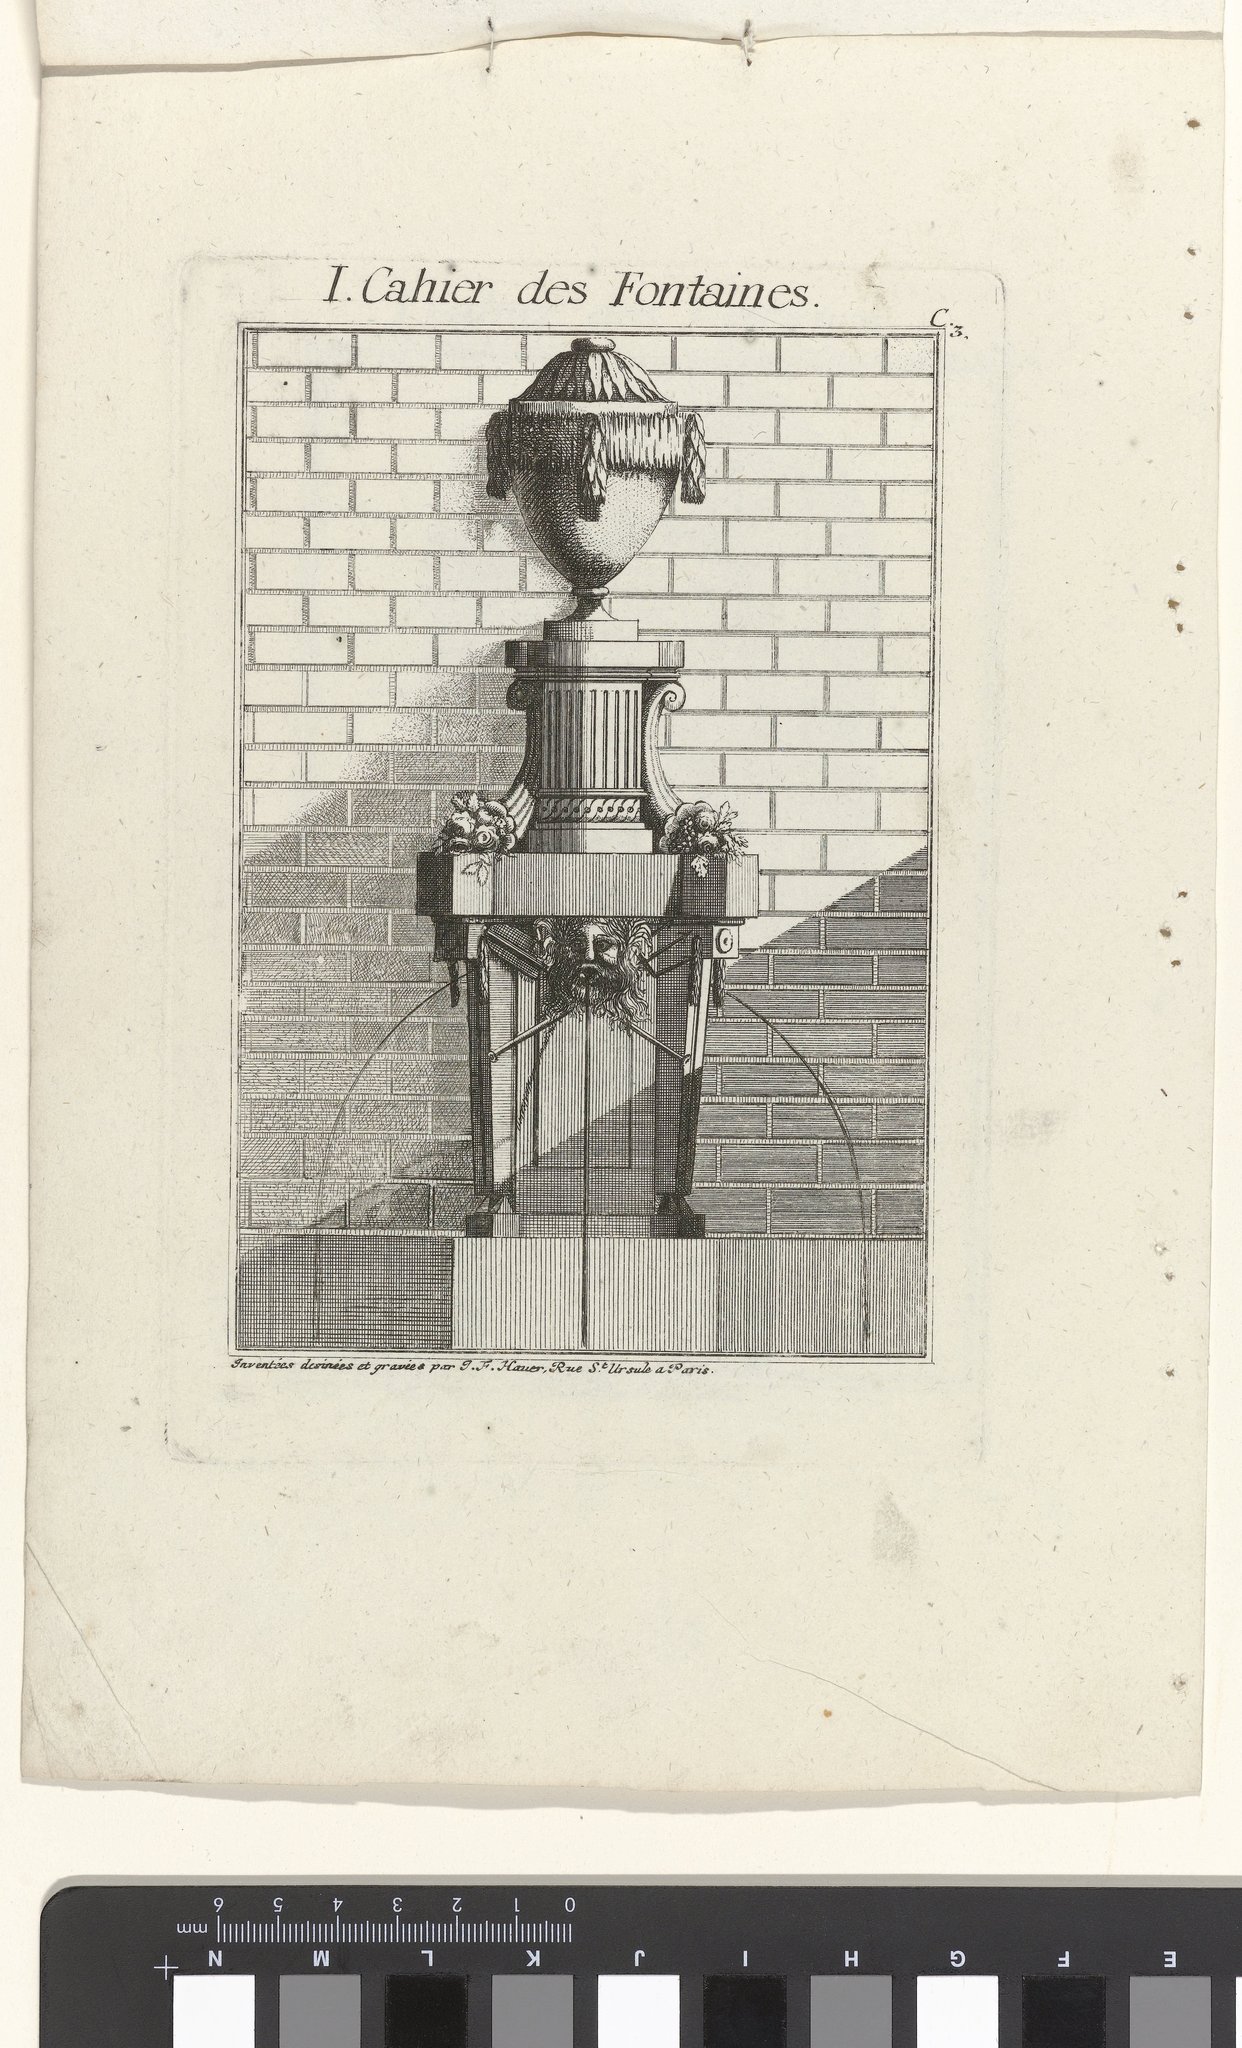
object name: print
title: Desseins de la Mode neuve au Gout antique (...)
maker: johann thomas hauer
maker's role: print maker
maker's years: 1748-1820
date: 1781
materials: paper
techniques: engraving, etching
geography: paris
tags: ornamental fountain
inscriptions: collector's mark: Lugt 2228, collector's mark: Lugt 2760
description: Ontwerp voor een pedestal met drie waterstromen waarvan één uit de mond van een saterachtige kop. Bovenop een antieke vaas.